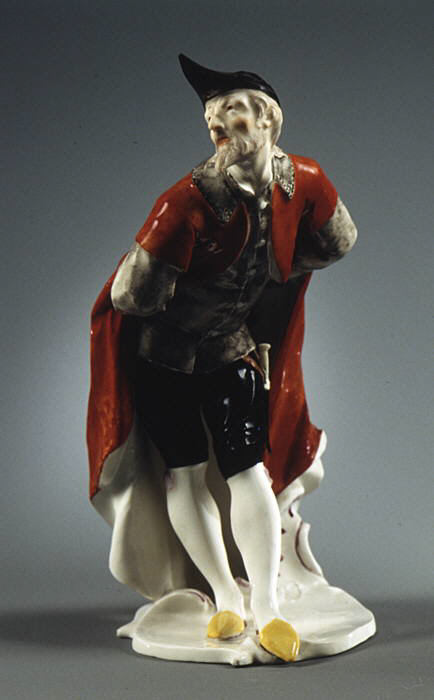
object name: figure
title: Pantaloon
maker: nymphenburg porcelain manufactory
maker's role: manufactory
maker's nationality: german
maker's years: 1747-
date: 1760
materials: hard paste porcelain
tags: men